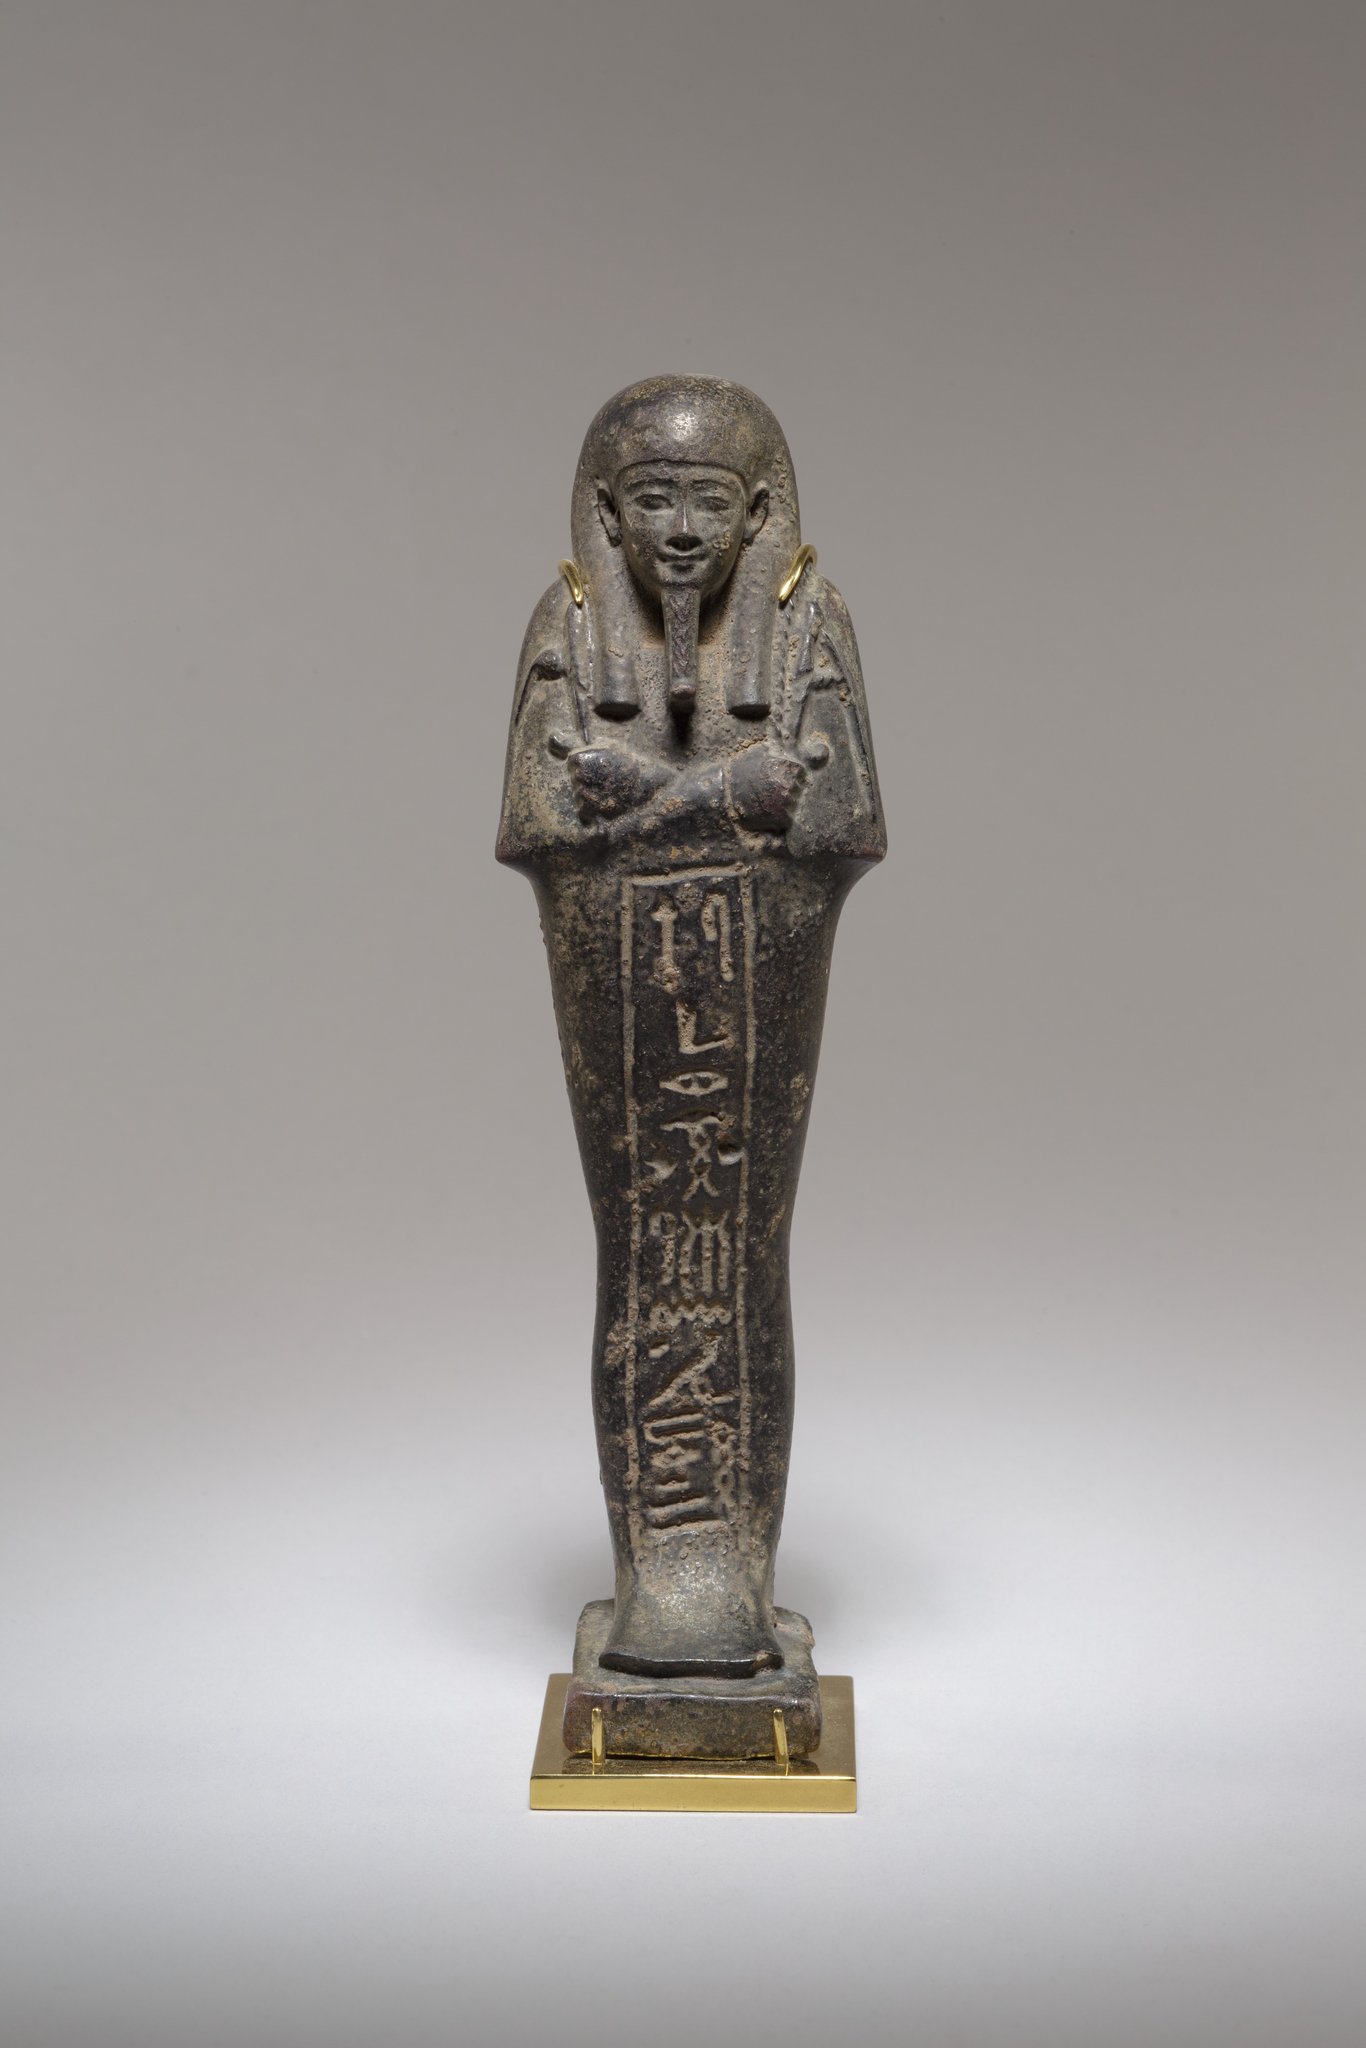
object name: shabti, wahibre, tahetret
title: Shabti of Wahibre, whose mother was Tahetret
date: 664-525 BCE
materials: faience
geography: memphite region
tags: hieroglyphs